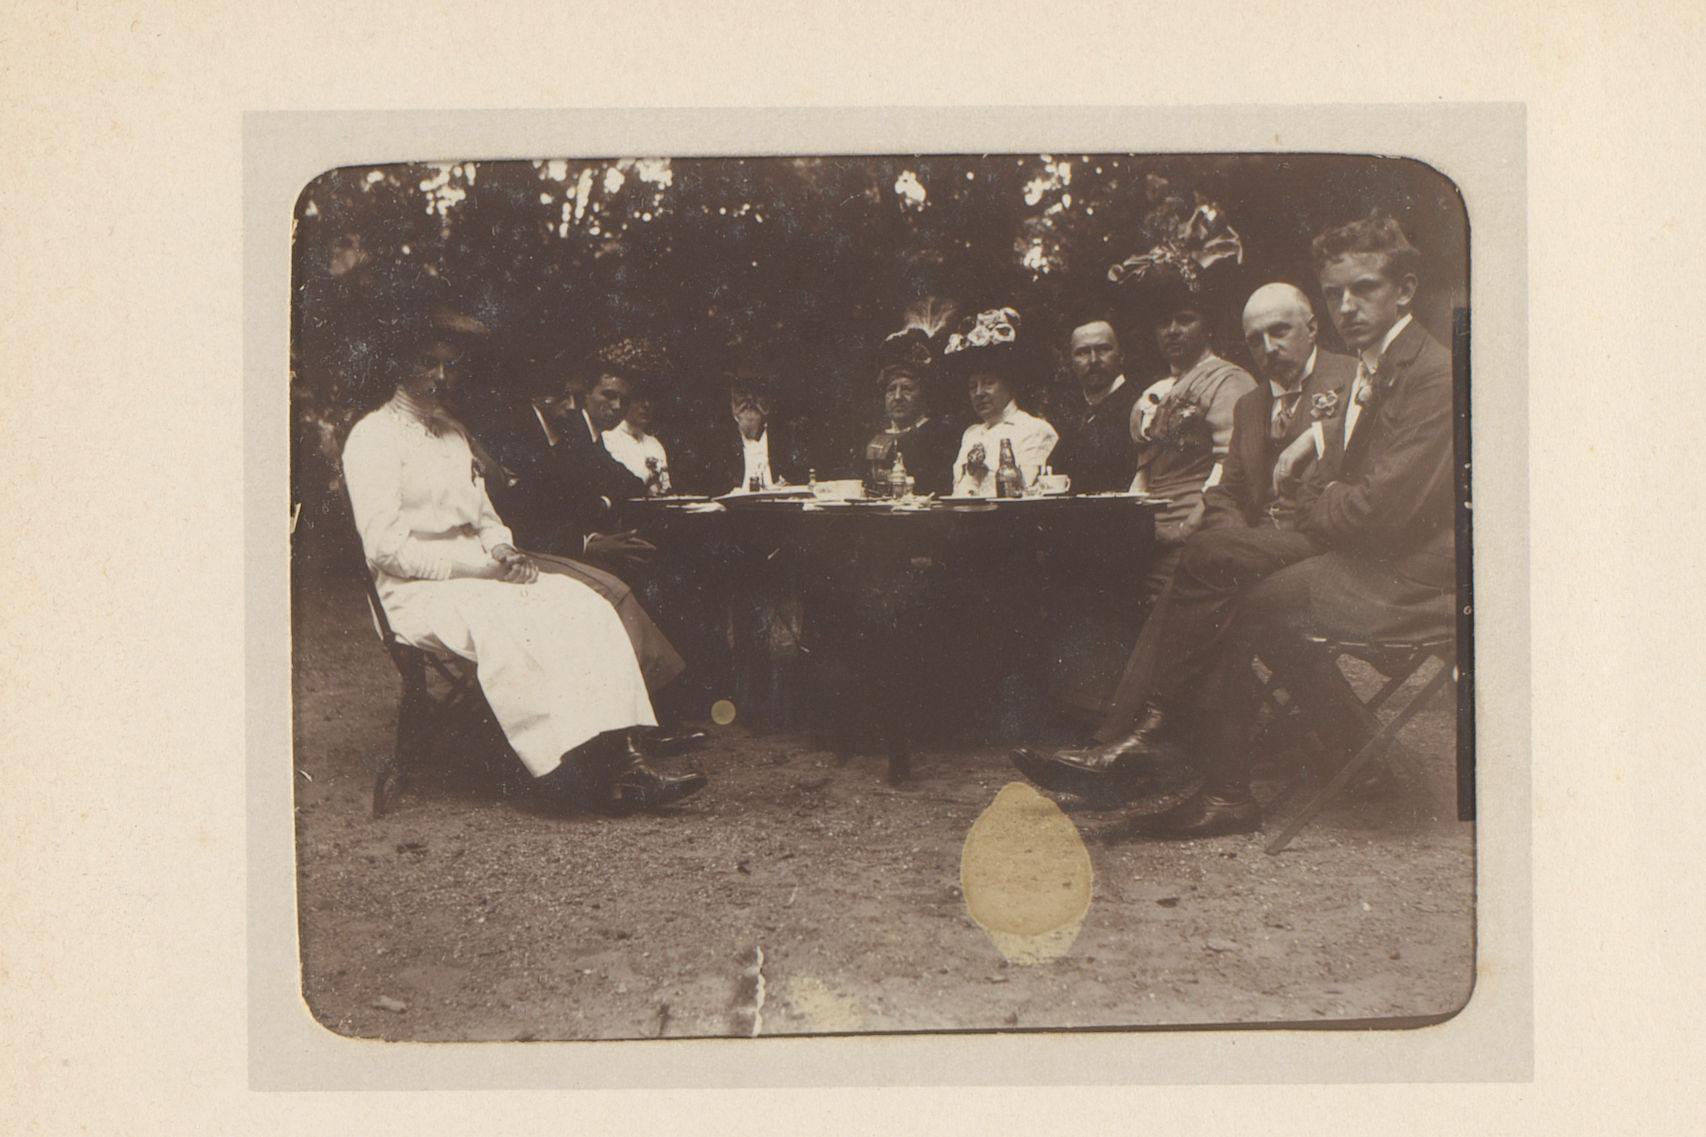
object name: album leaf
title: Groepsportret van een gezelschap rondom een tafel in het bos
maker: liesbeth overhoff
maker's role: fotograaf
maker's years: 1895-1969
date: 1911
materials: paper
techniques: collodion silver print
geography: baarn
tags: evening meal, dinner, supper - cc - out of doors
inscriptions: inscription: ‘Baarn 1911’